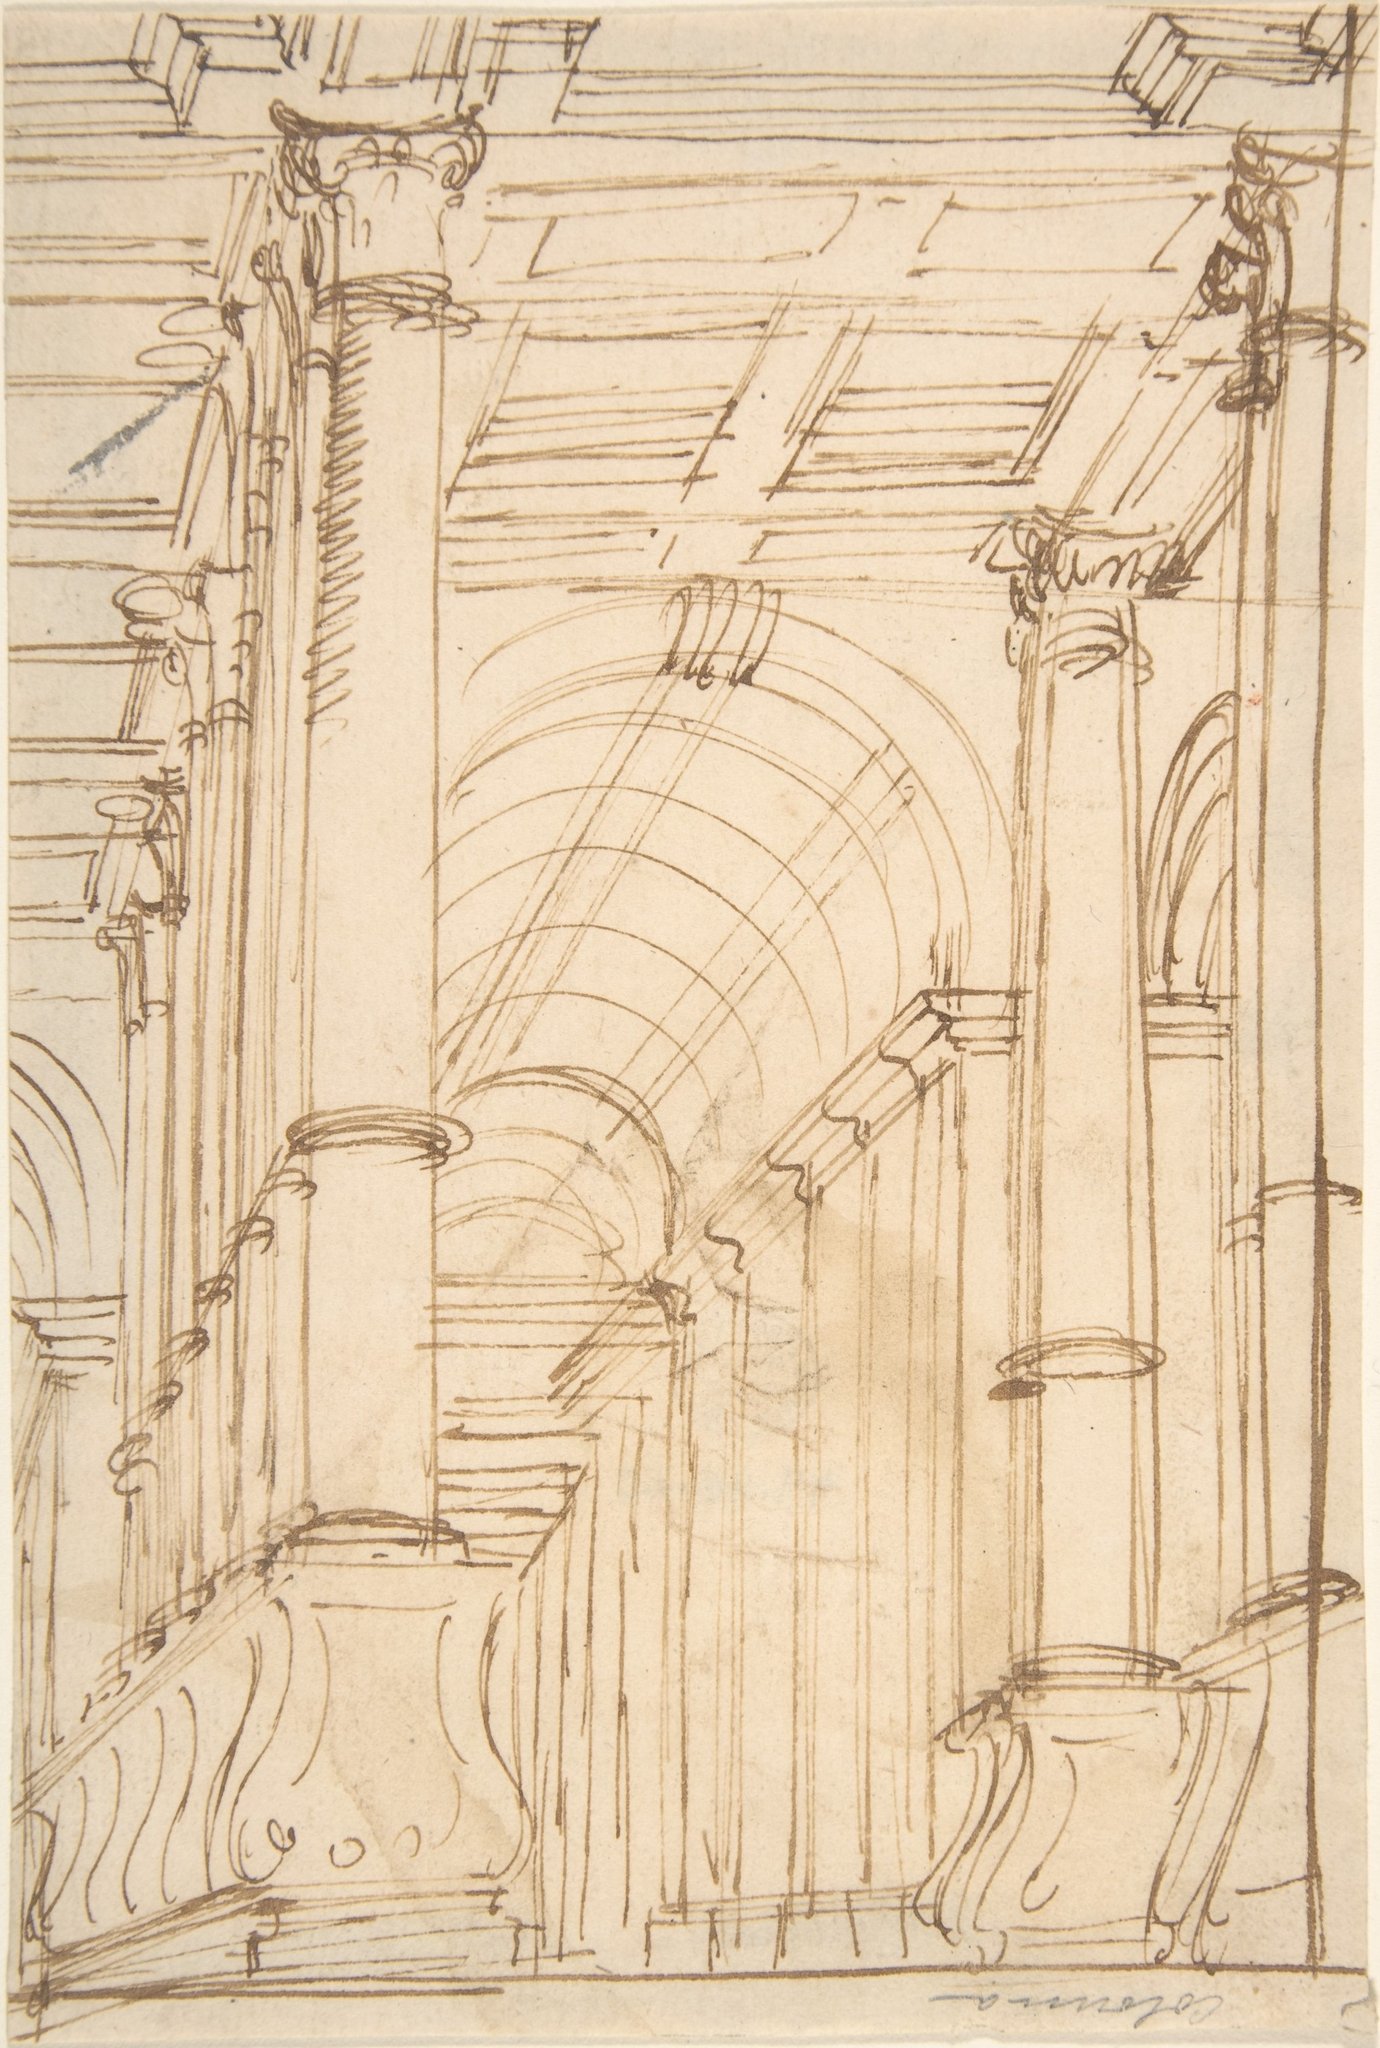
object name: drawing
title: Design for a Console supported by Putto (recto); Architectural Arcade (verso)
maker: anonymous, italian, 17th century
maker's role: artist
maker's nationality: italian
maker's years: 1600-1700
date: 1601-1700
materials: graphite, ink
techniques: brush, pen, drawing, wash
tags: architecture,columns